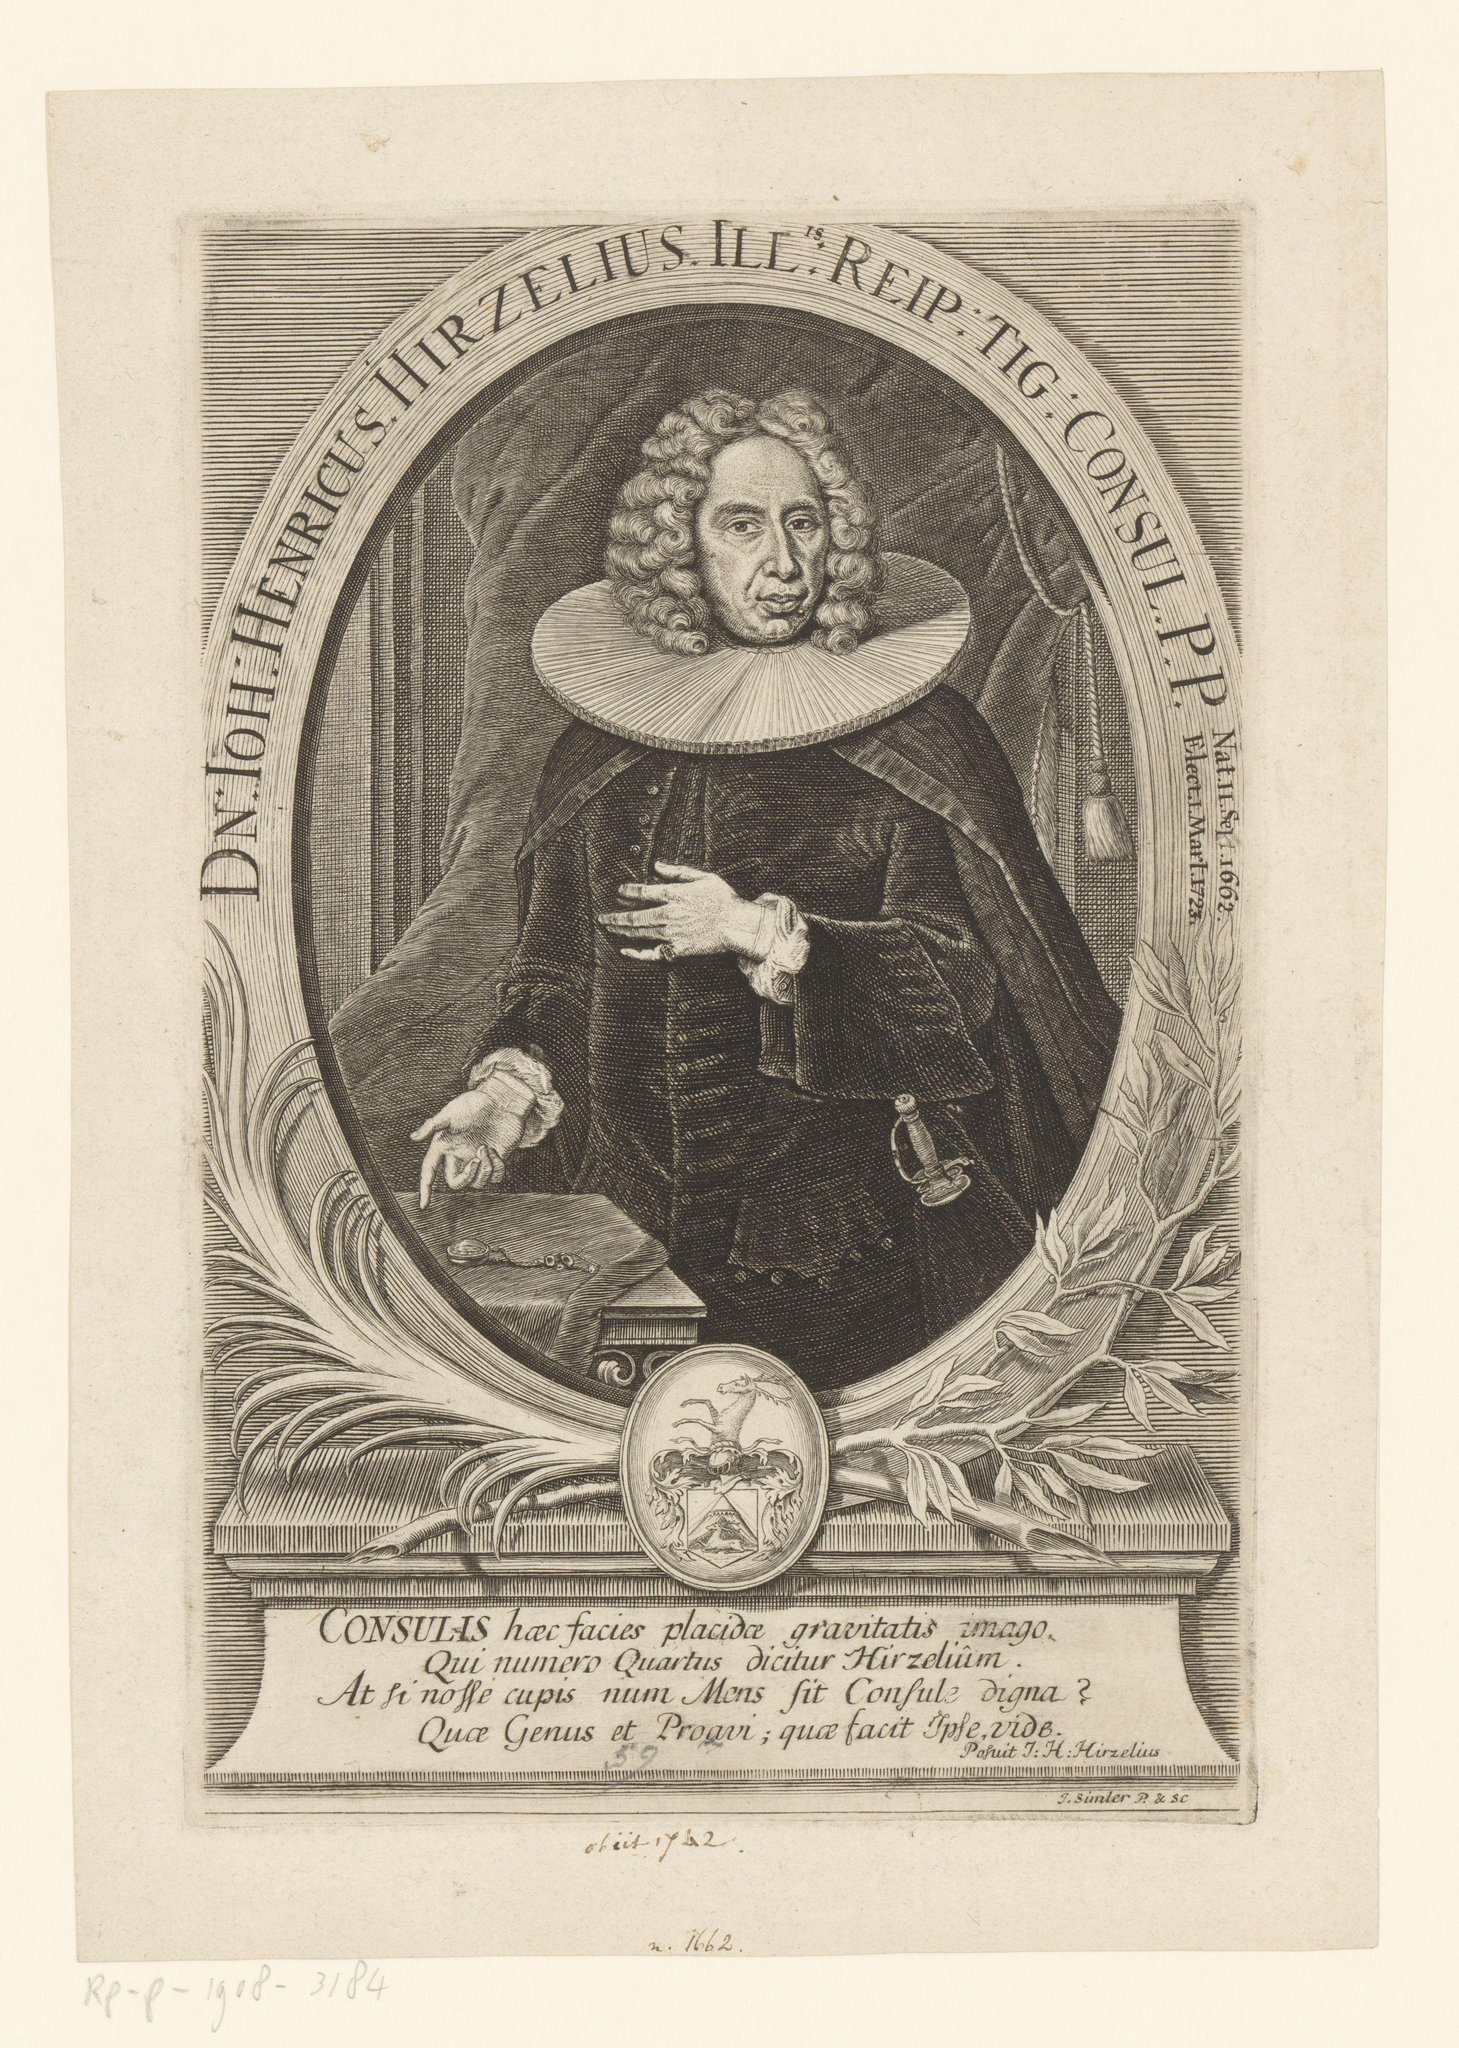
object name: print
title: Portret van Hans Heinrich Hirzel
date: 1703-1748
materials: paper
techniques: engraving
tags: switzerland, hacking and thrusting weapons, historical persons, compass, armorial bearing, heraldry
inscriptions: collector's mark: Lugt 2228